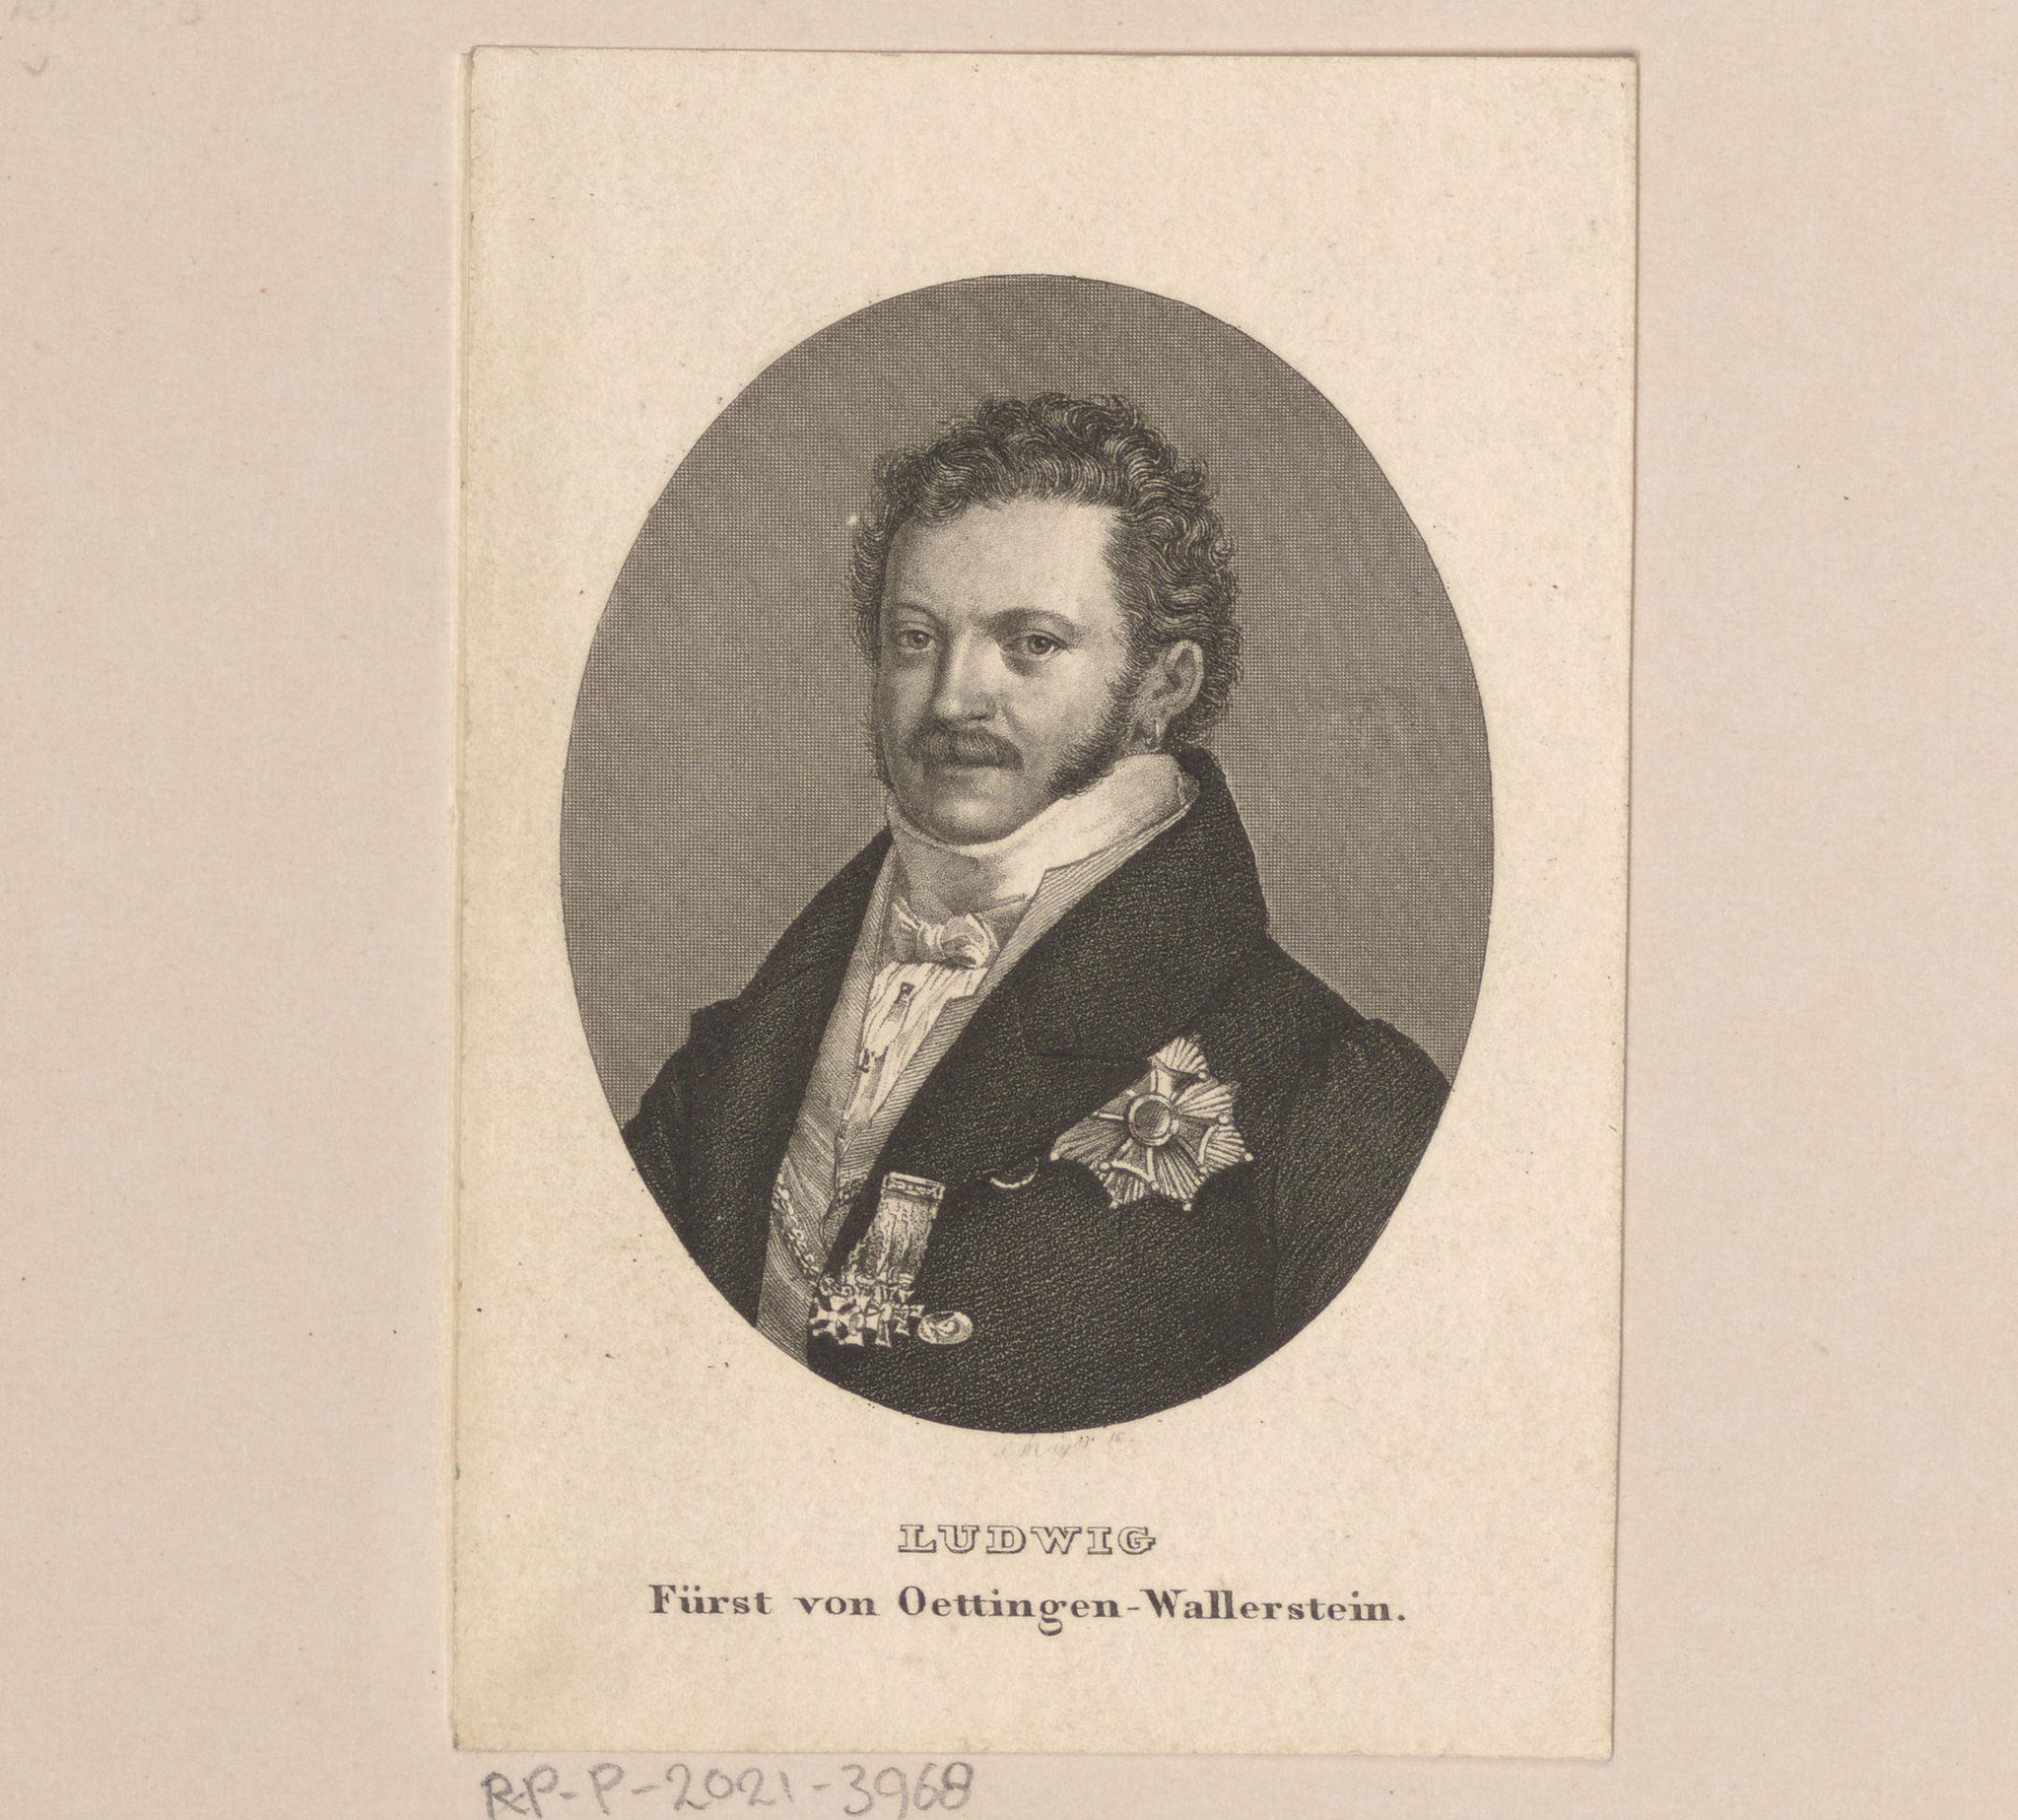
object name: print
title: Portret van Ludwig Fürst von Oettingen-Wallerstein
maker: carl mayer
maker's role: print maker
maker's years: 1798-1868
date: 1808-1869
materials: paper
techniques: engraving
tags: historical persons, medals and other marks of military honour